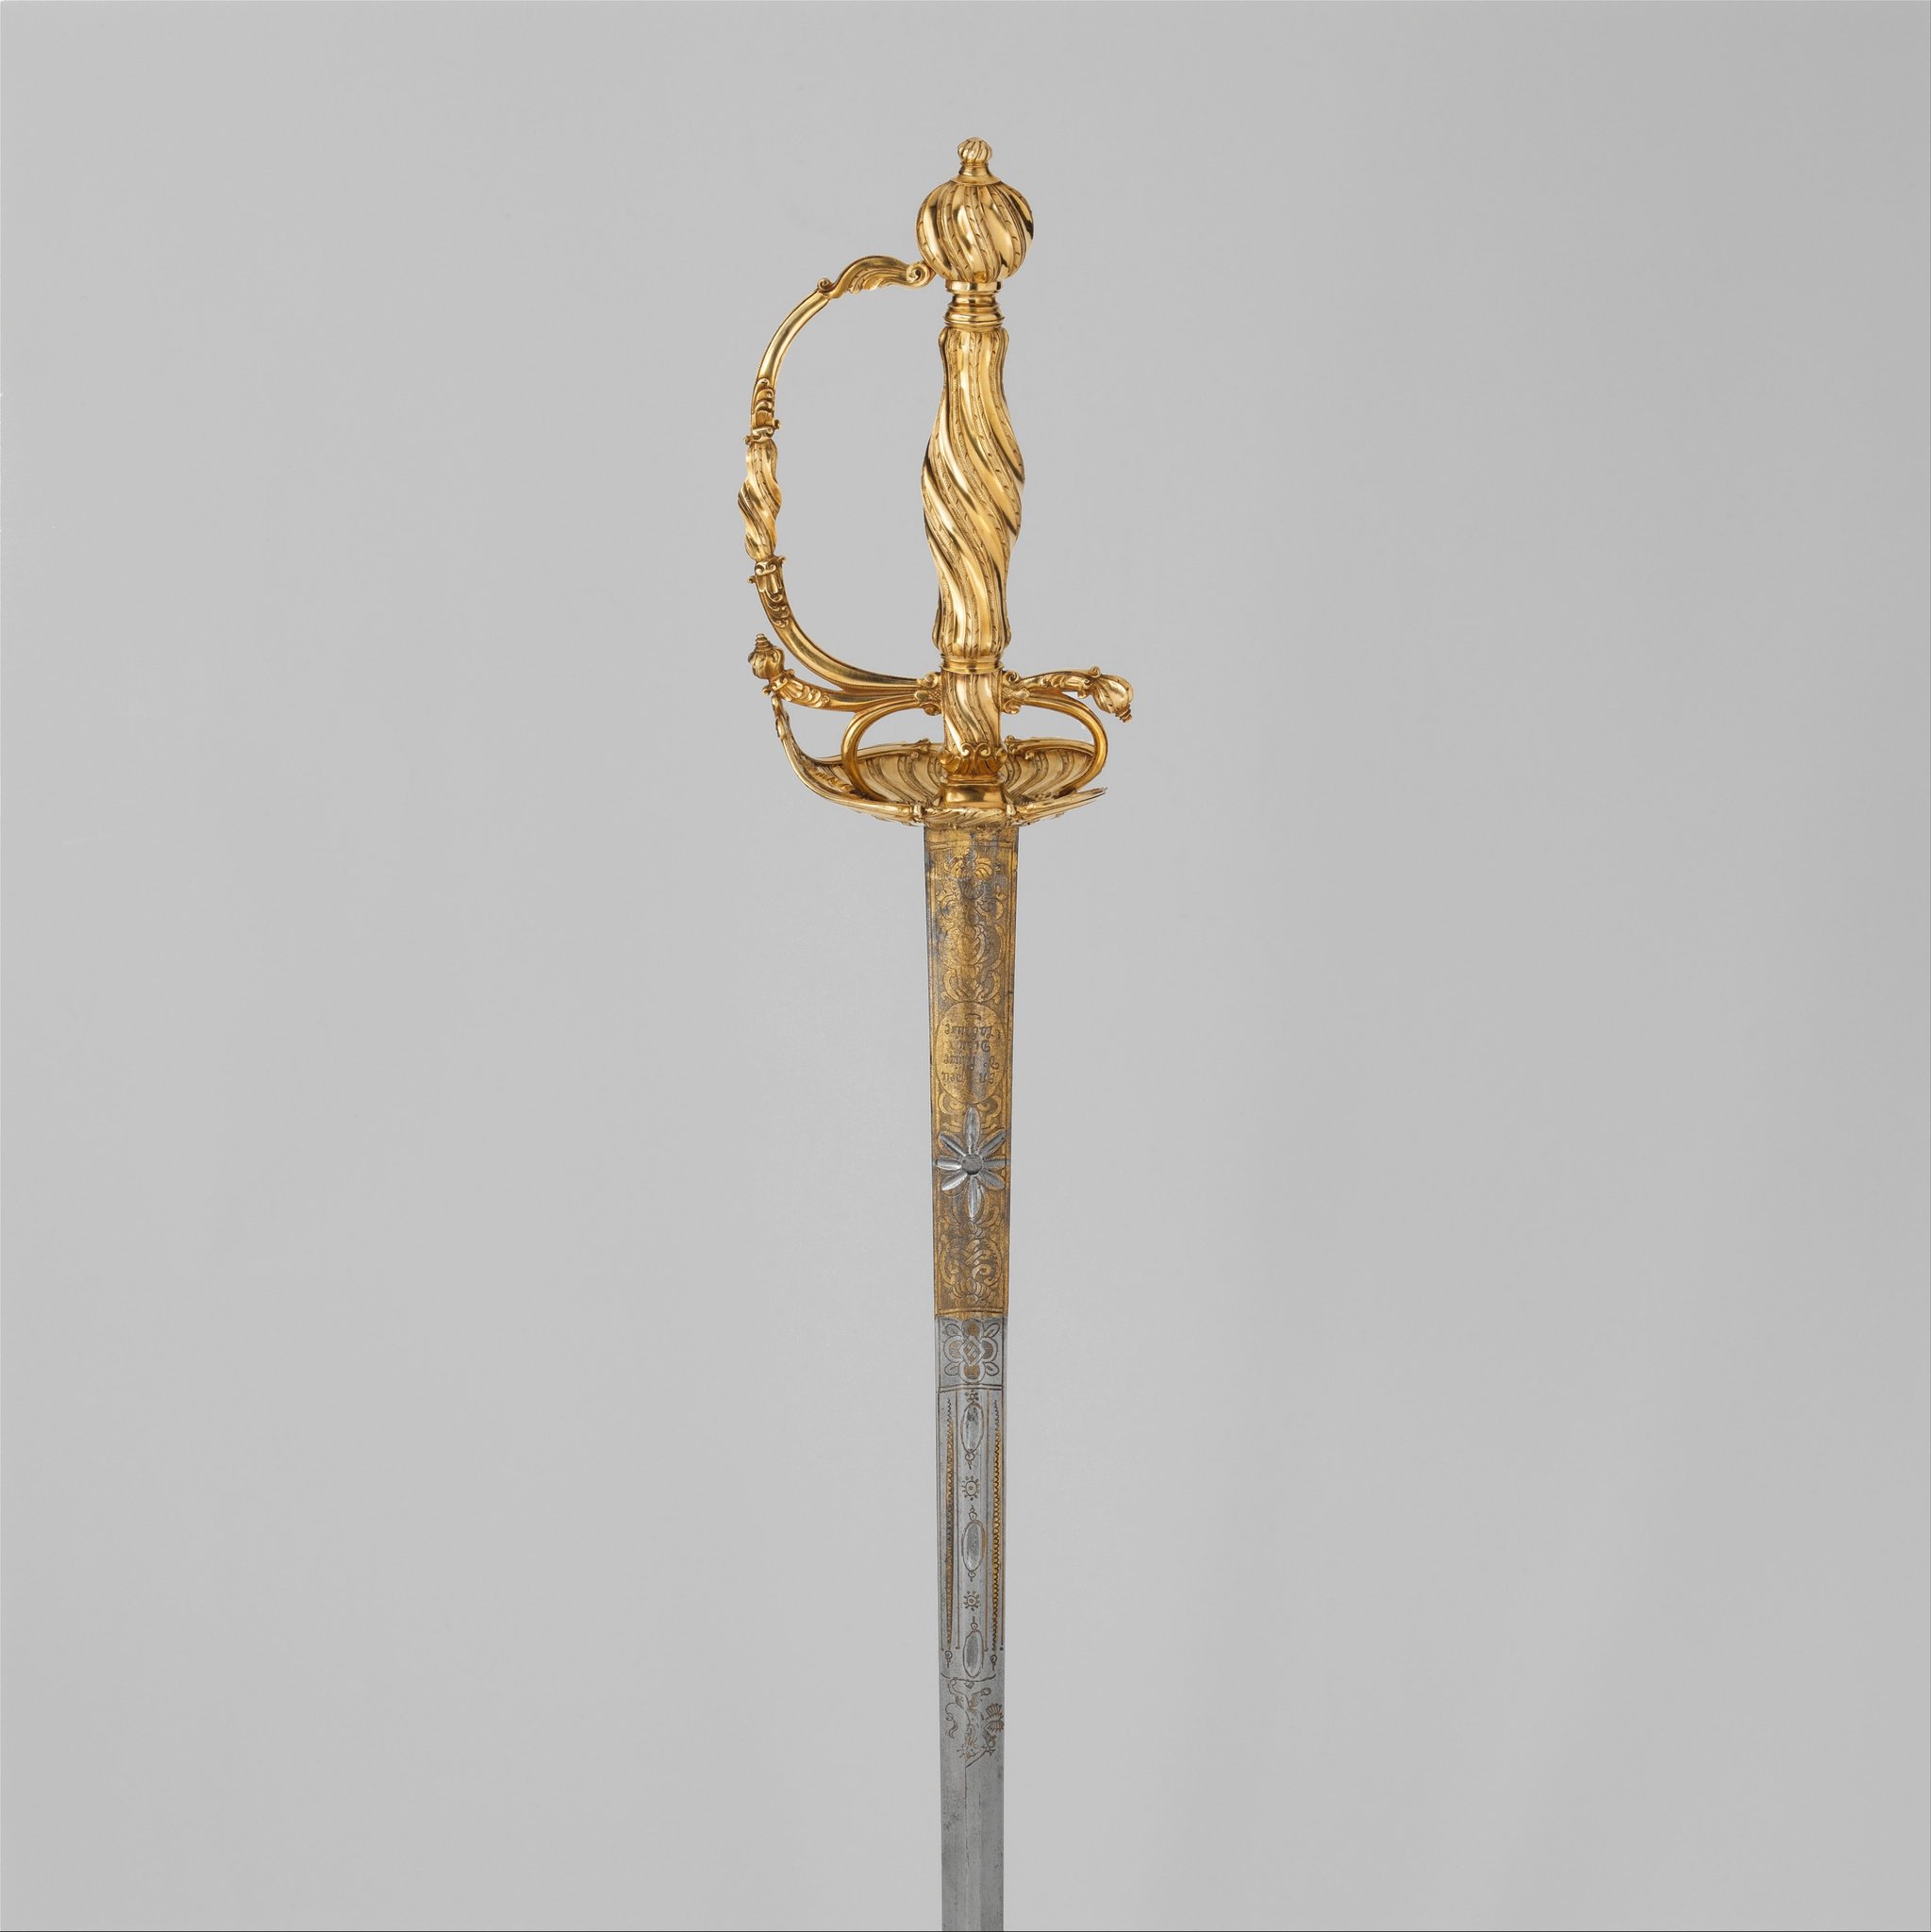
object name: smallsword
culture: dutch or german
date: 1750-1760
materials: gold, steel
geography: germany